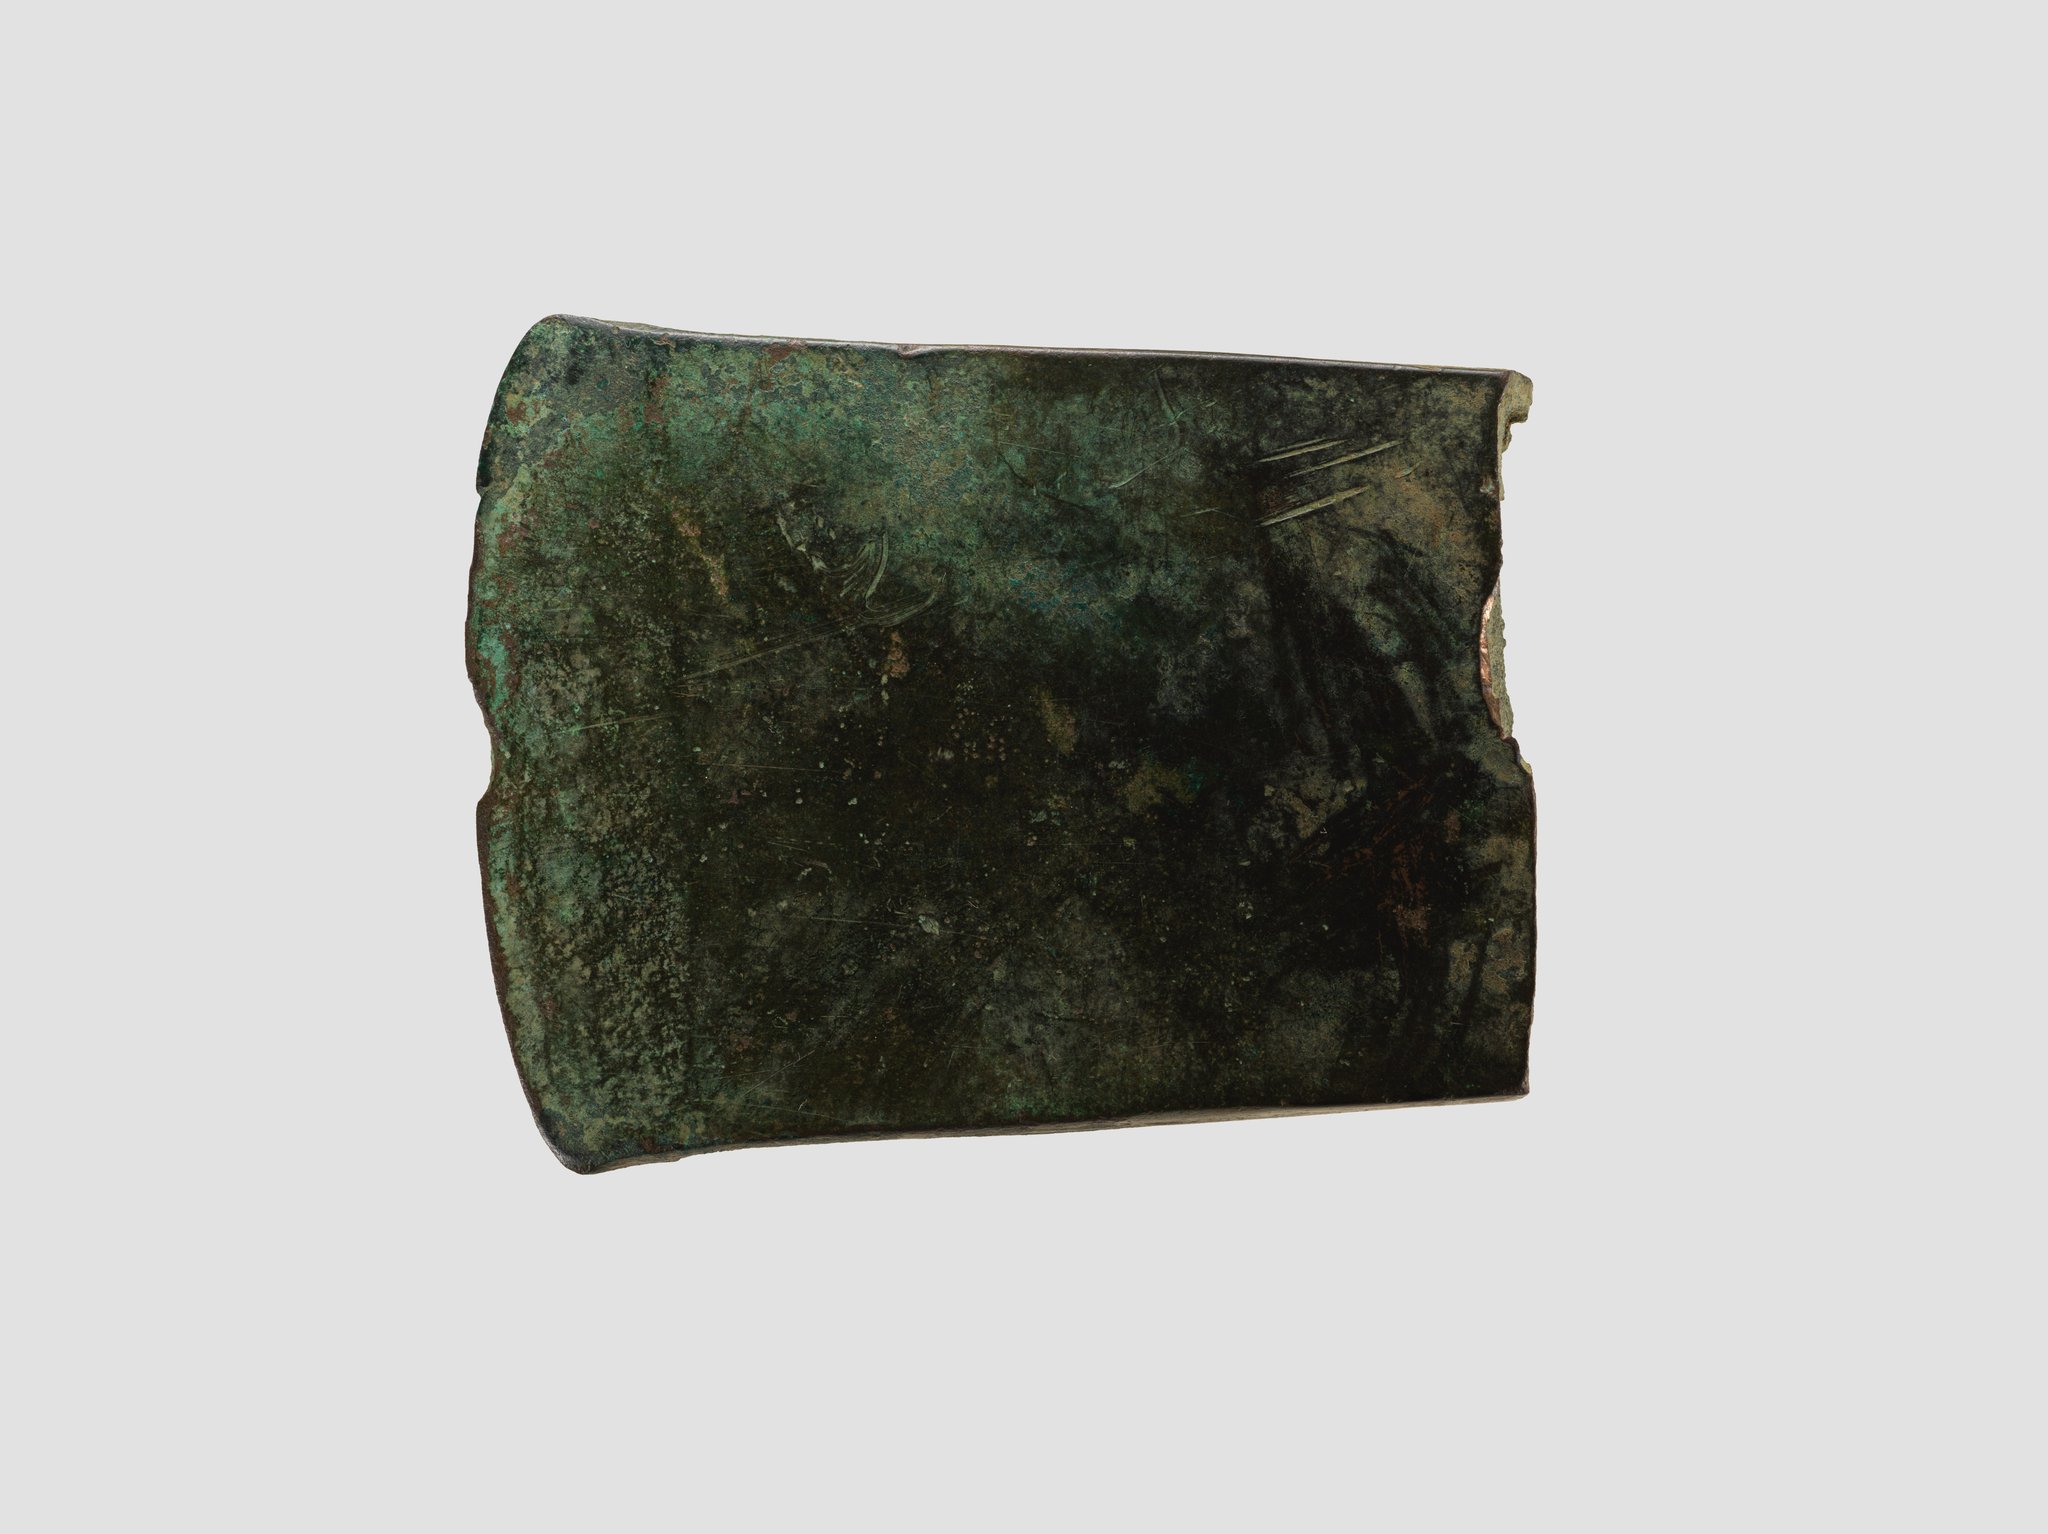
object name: axe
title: Axe head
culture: hattian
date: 2300-2000 BCE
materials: bronze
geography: central anatolia